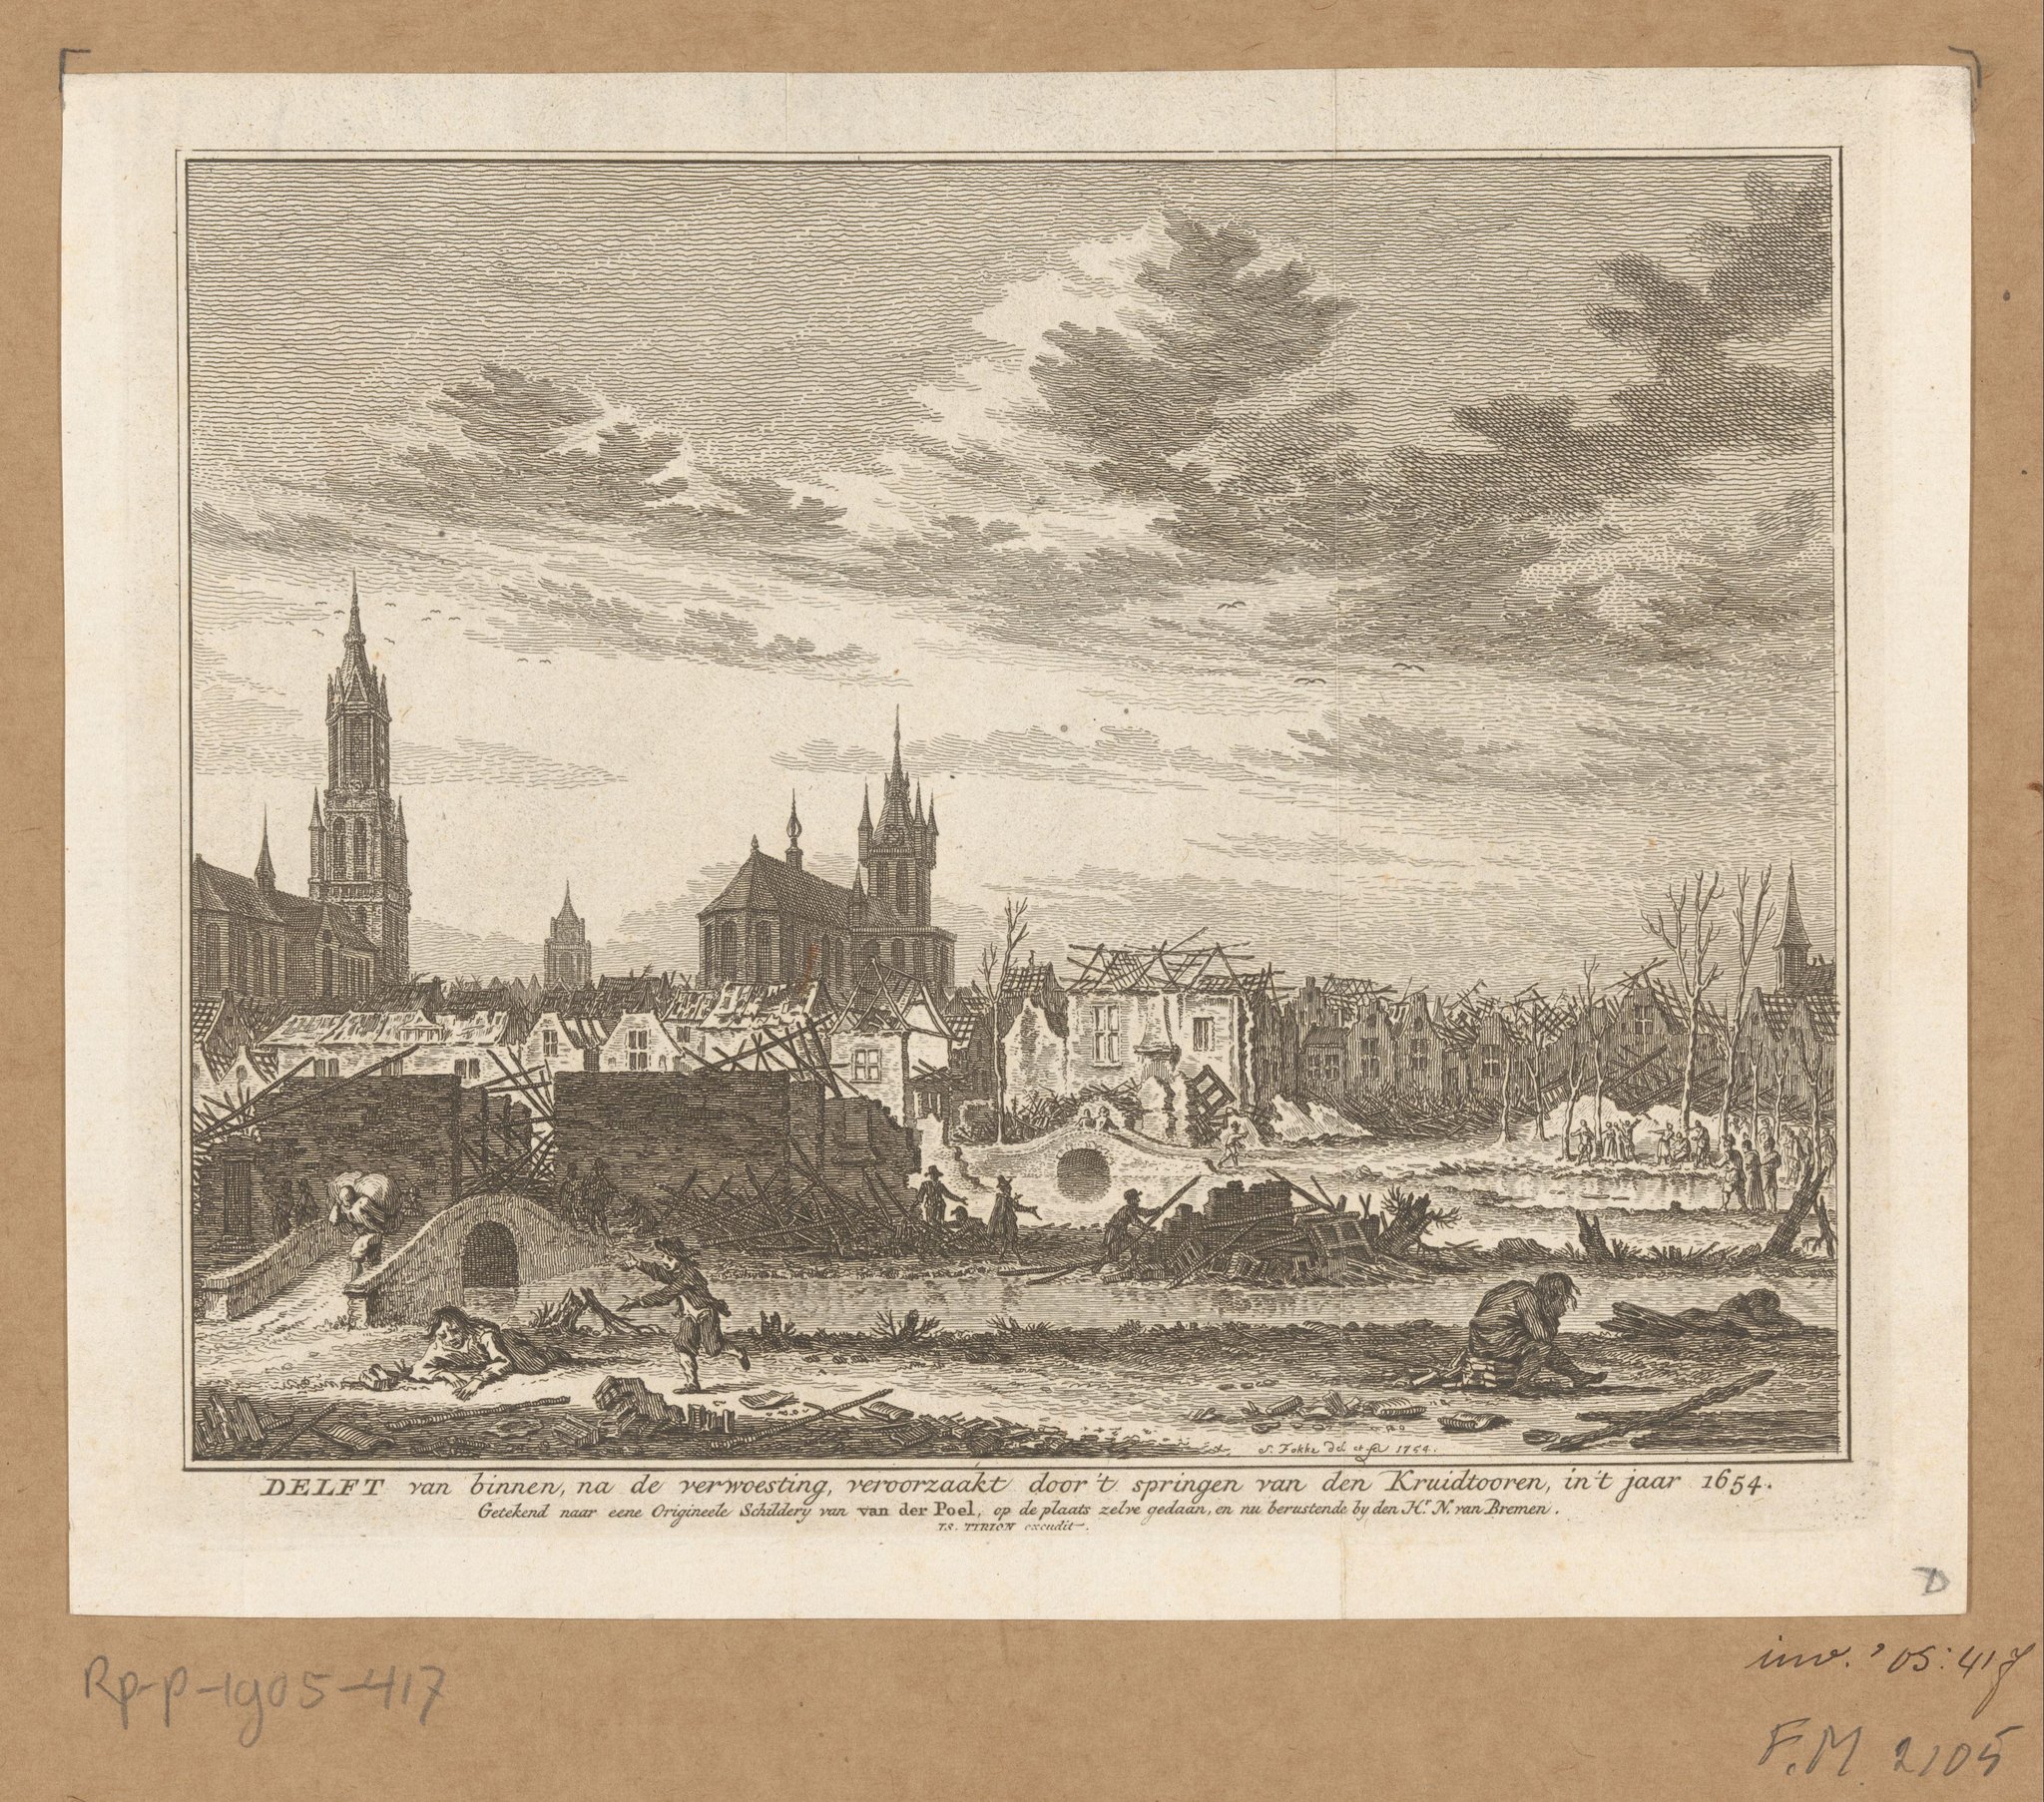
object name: book illustration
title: Verwoesting in Delft na de ontploffing van het buskruitmagazijn op 12 oktober 1654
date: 1754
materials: paper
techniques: etching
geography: amsterdam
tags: ruin of a dwelling, house, castle, etc., gunpowder disaster, delft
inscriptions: collector's mark: Lugt 2228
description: Prent uit: Wagenaar, Jan. Vaderlandsche Historie (...). Amsterdam: Isaak Tirion, 1755, dl. 12, p. 434-435.